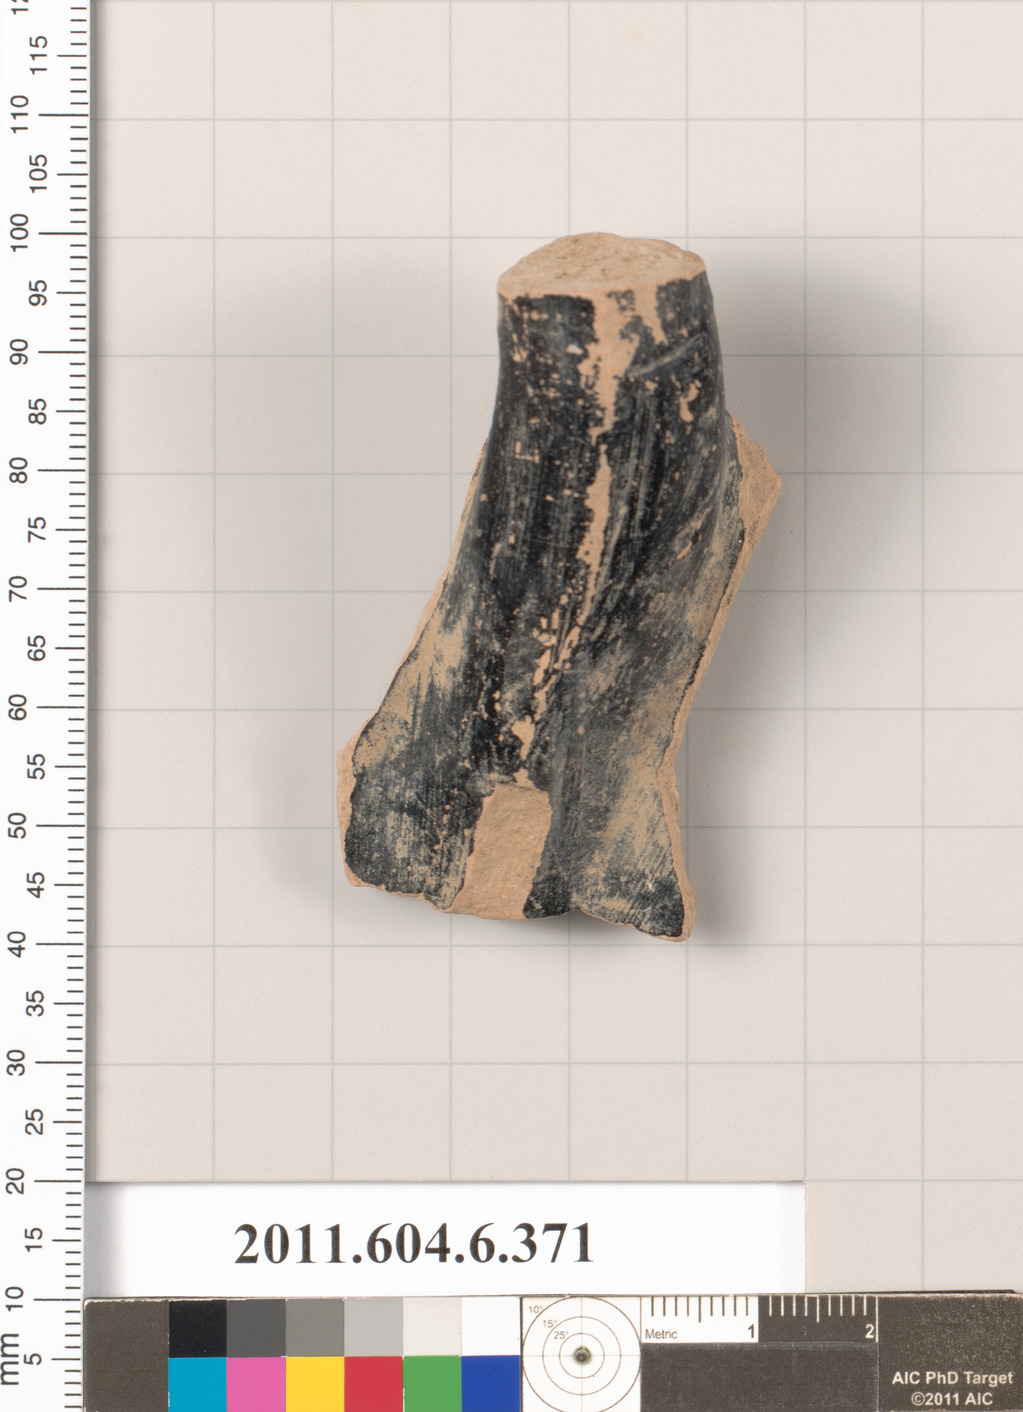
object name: undetermined shape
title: Terracotta fragment of an undetermined shape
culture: greek, attic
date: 600-401 BCE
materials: terracotta